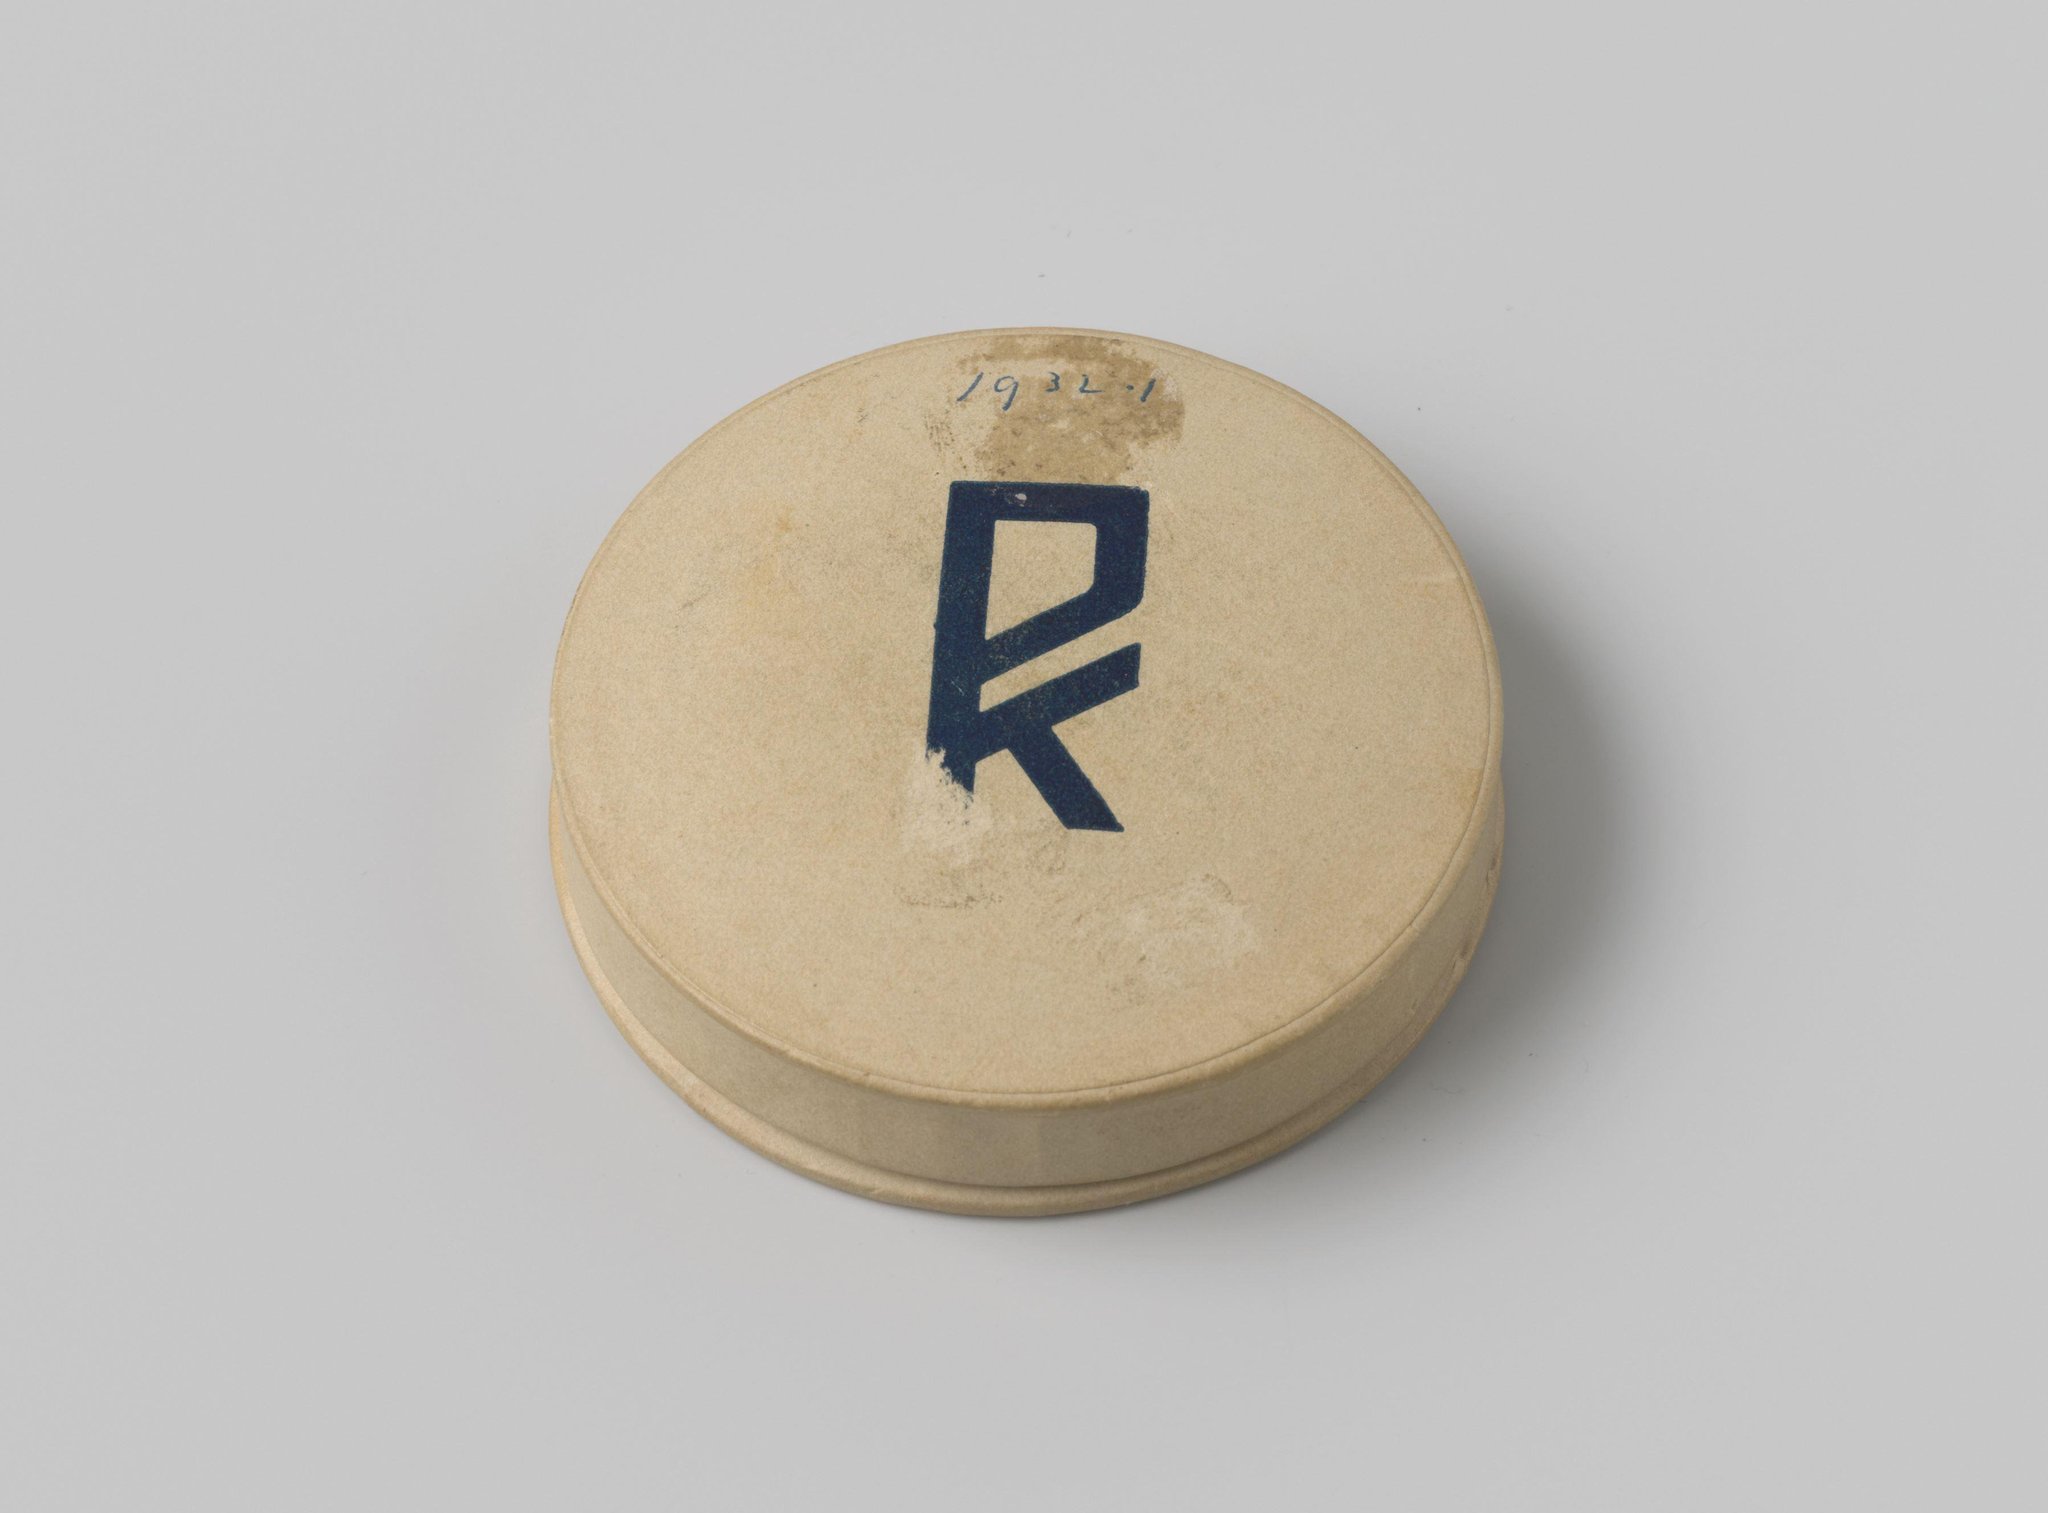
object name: history medal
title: Een kartonnen doosje horend bij een bronzen penning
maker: dirk wolbers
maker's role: designer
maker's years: 1890-1957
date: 1929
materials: cardboard, velvet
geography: voorschoten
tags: bandung, eindhoven, kootwijk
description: Een kartonnen doosje met monogram op bovenzijde en opschrift op binnenzijde van deksel; binnenzijde bodem bekleed met paars fluweel